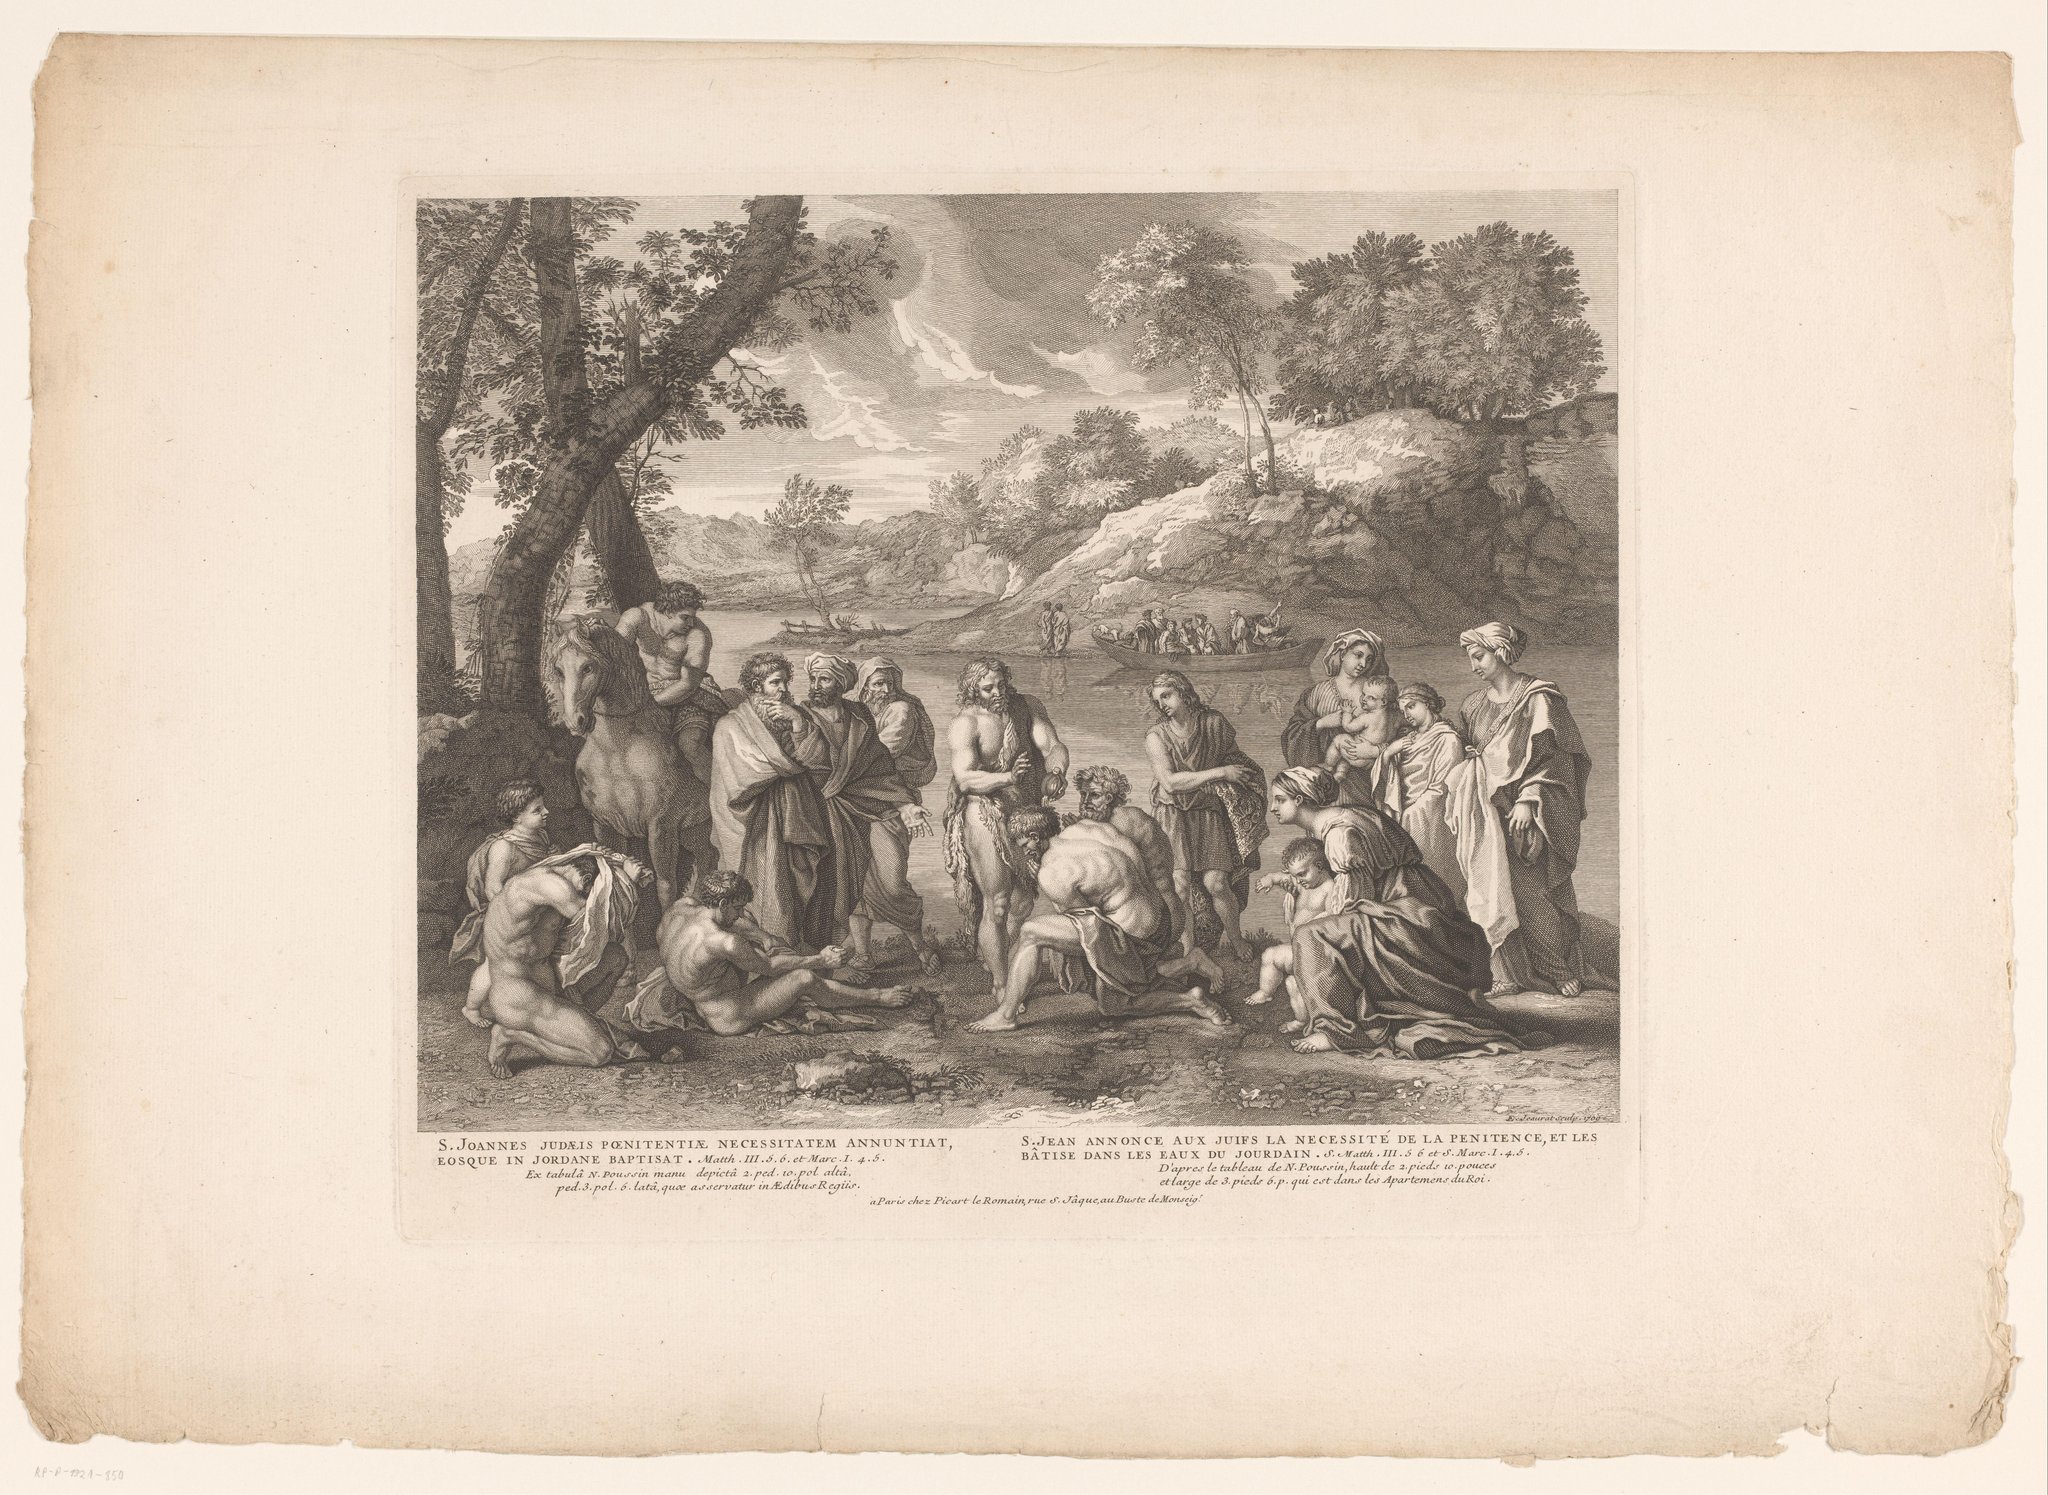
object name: print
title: Johannes doopt het volk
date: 1709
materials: paper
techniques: engraving, etching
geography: france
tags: john the baptist baptizing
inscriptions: collector's mark: Lugt 2233